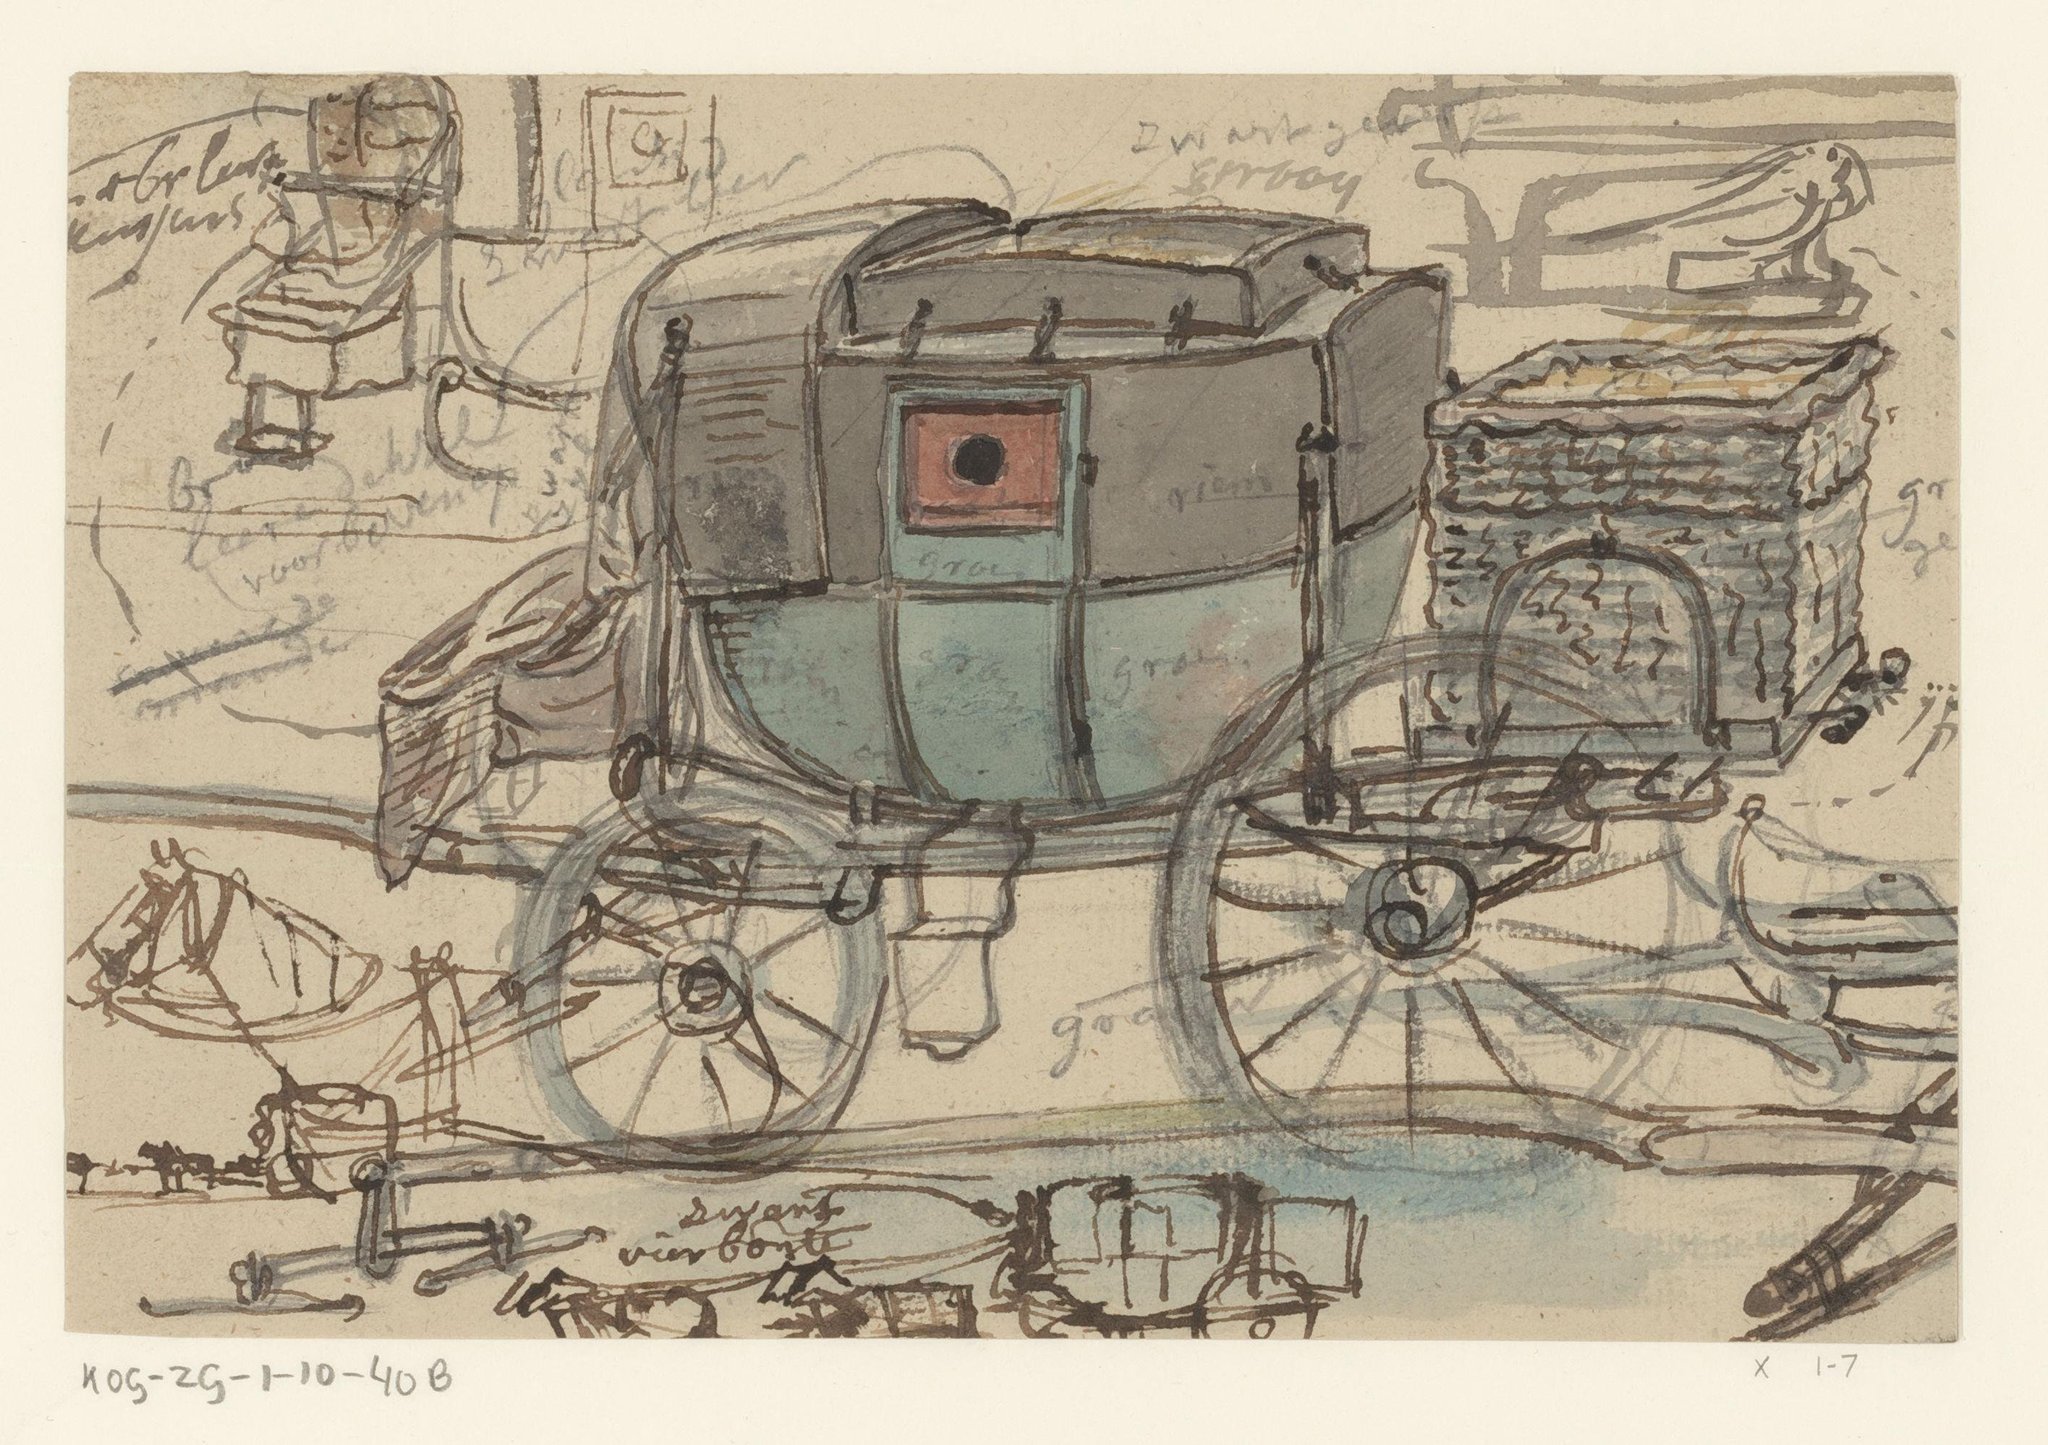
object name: drawing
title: Koets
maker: Anonymous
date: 1800-1899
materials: ink, paper, pencil, watercolor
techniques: brush, pen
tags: four-wheeled, animal-drawn vehicle, e.g.: cab, carriage, coach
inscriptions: kleurnotitie, handgeschreven, handgeschreven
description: Onderwerpsrubrieken binnen de Atlas Zeden en Gewoonten: Vervoermiddelen te land en te water, Vervoermiddelen te land, Reiskoetsen en post.